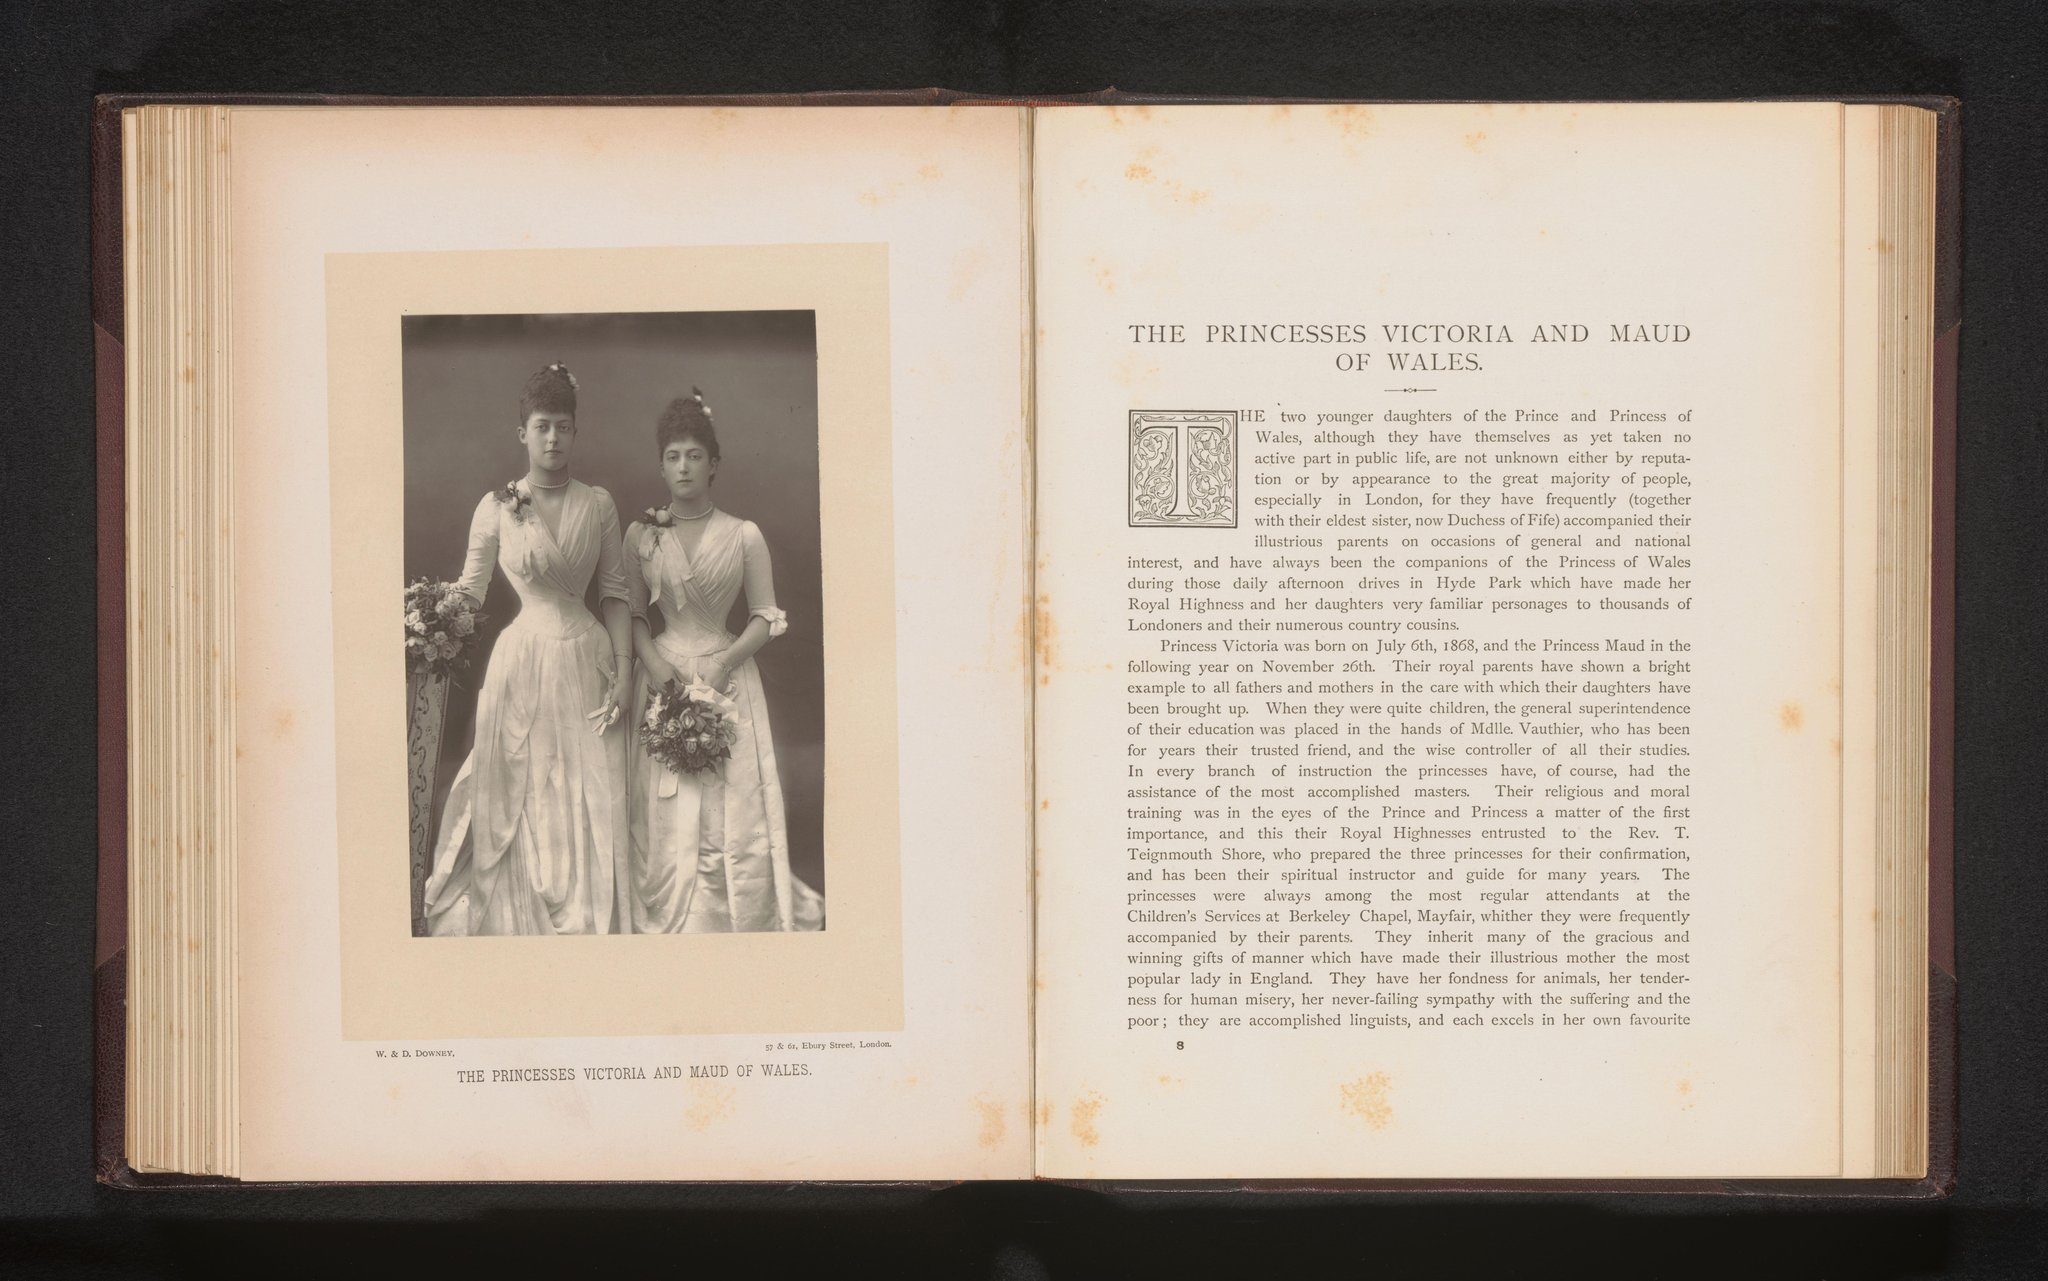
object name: photograph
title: Portret van Victoria en Maud, prinsessen van Wales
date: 1885-1890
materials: paper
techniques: carbon print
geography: london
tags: historical persons - bb - woman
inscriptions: address: ‘57 & 61, Ebury Street, London.’